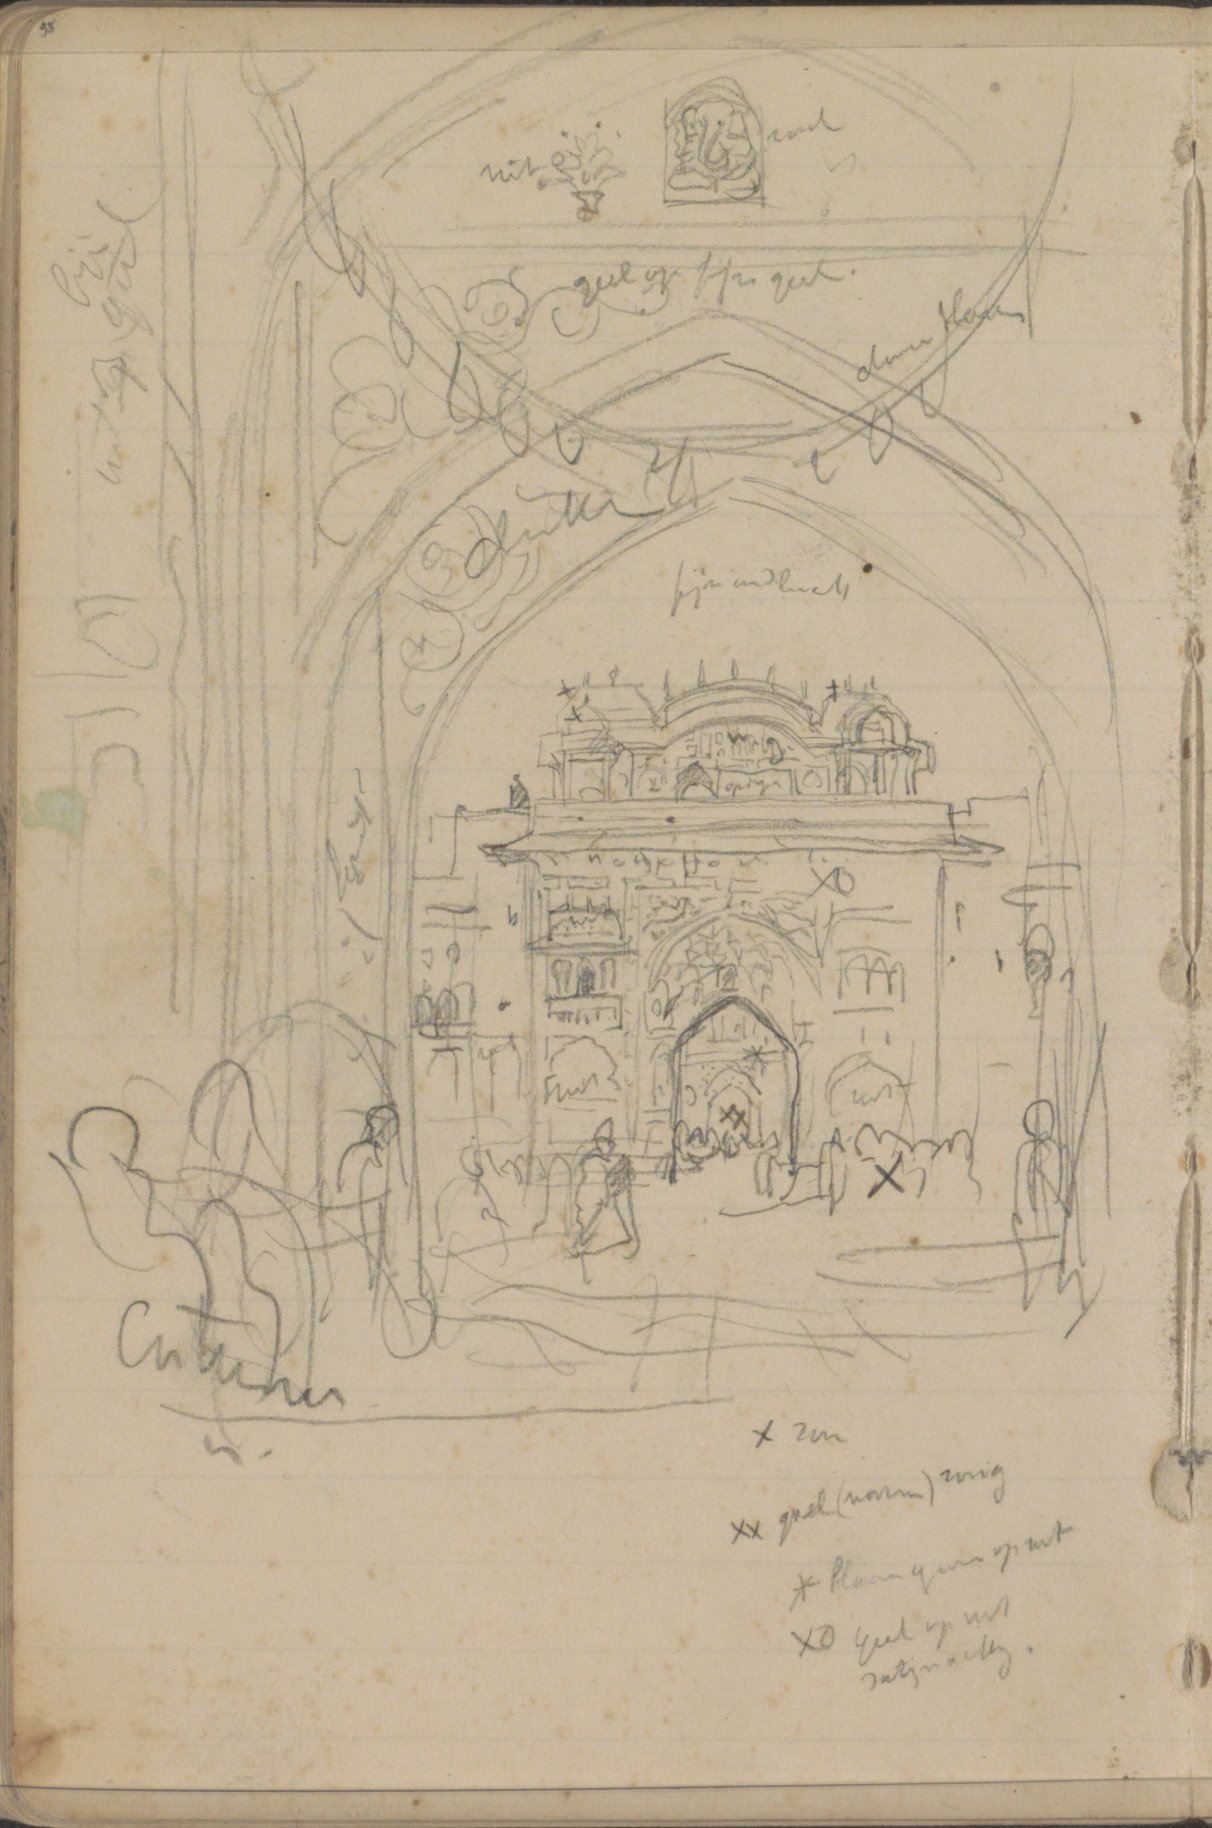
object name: sketchbook leaf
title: Straat met poorten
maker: marius bauer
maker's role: draughtsman, print maker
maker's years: 1867-1932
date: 1897-1898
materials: pencil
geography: india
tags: architecture, street (+ city(-scape) with figures, staffage)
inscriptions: annotation: ‘C[...]tunen?’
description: Pagina 95 uit een schetsboek met 84 bladen.